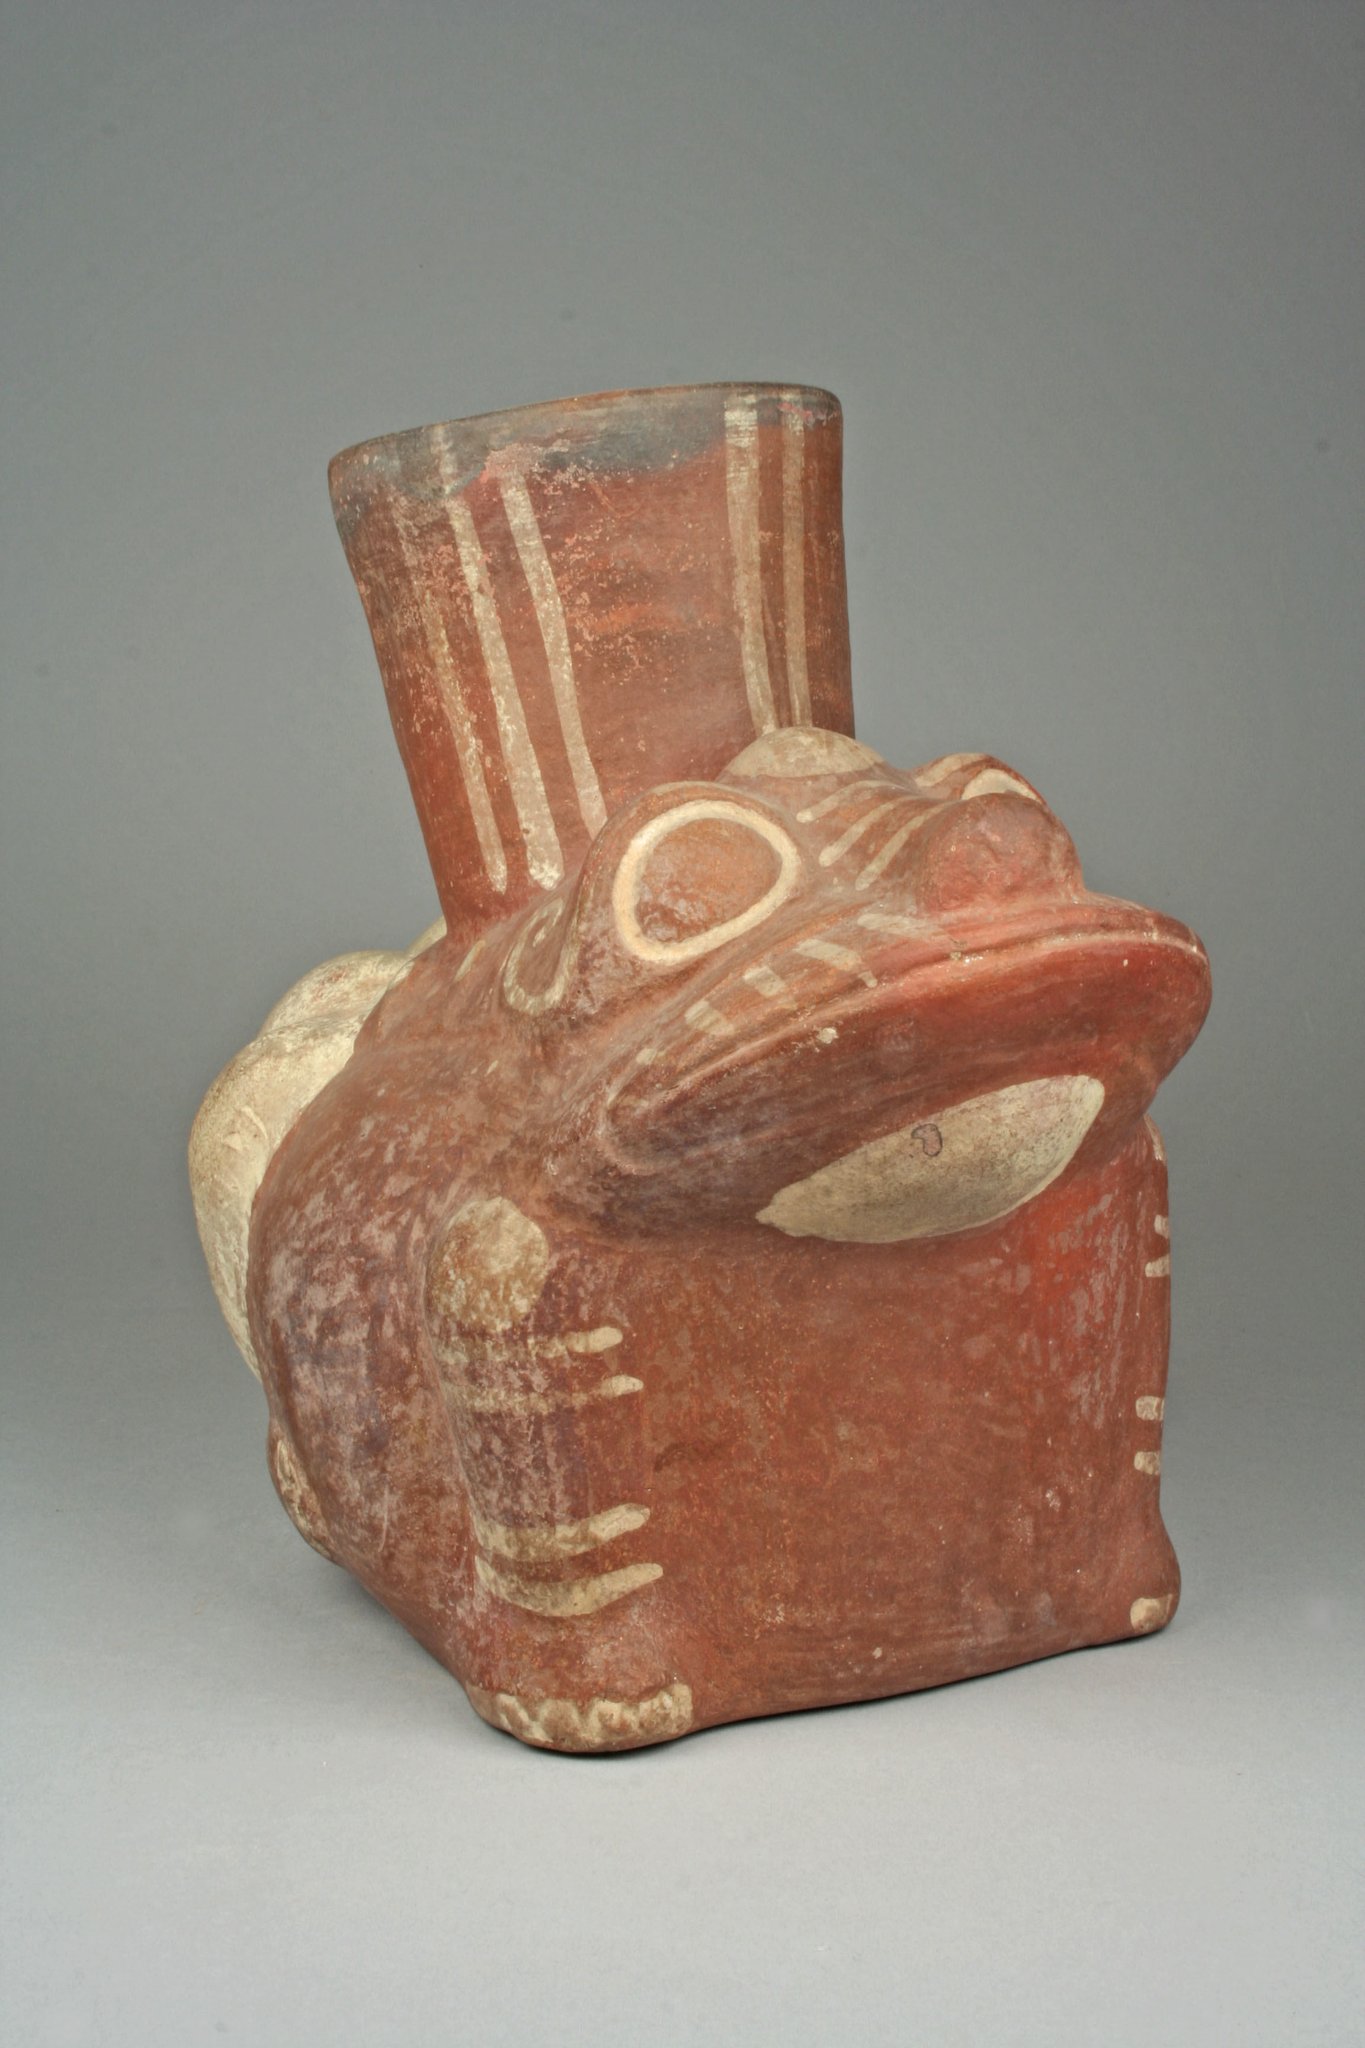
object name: bottle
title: Frog Bottle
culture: moche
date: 301-700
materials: ceramic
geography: peru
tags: frogs